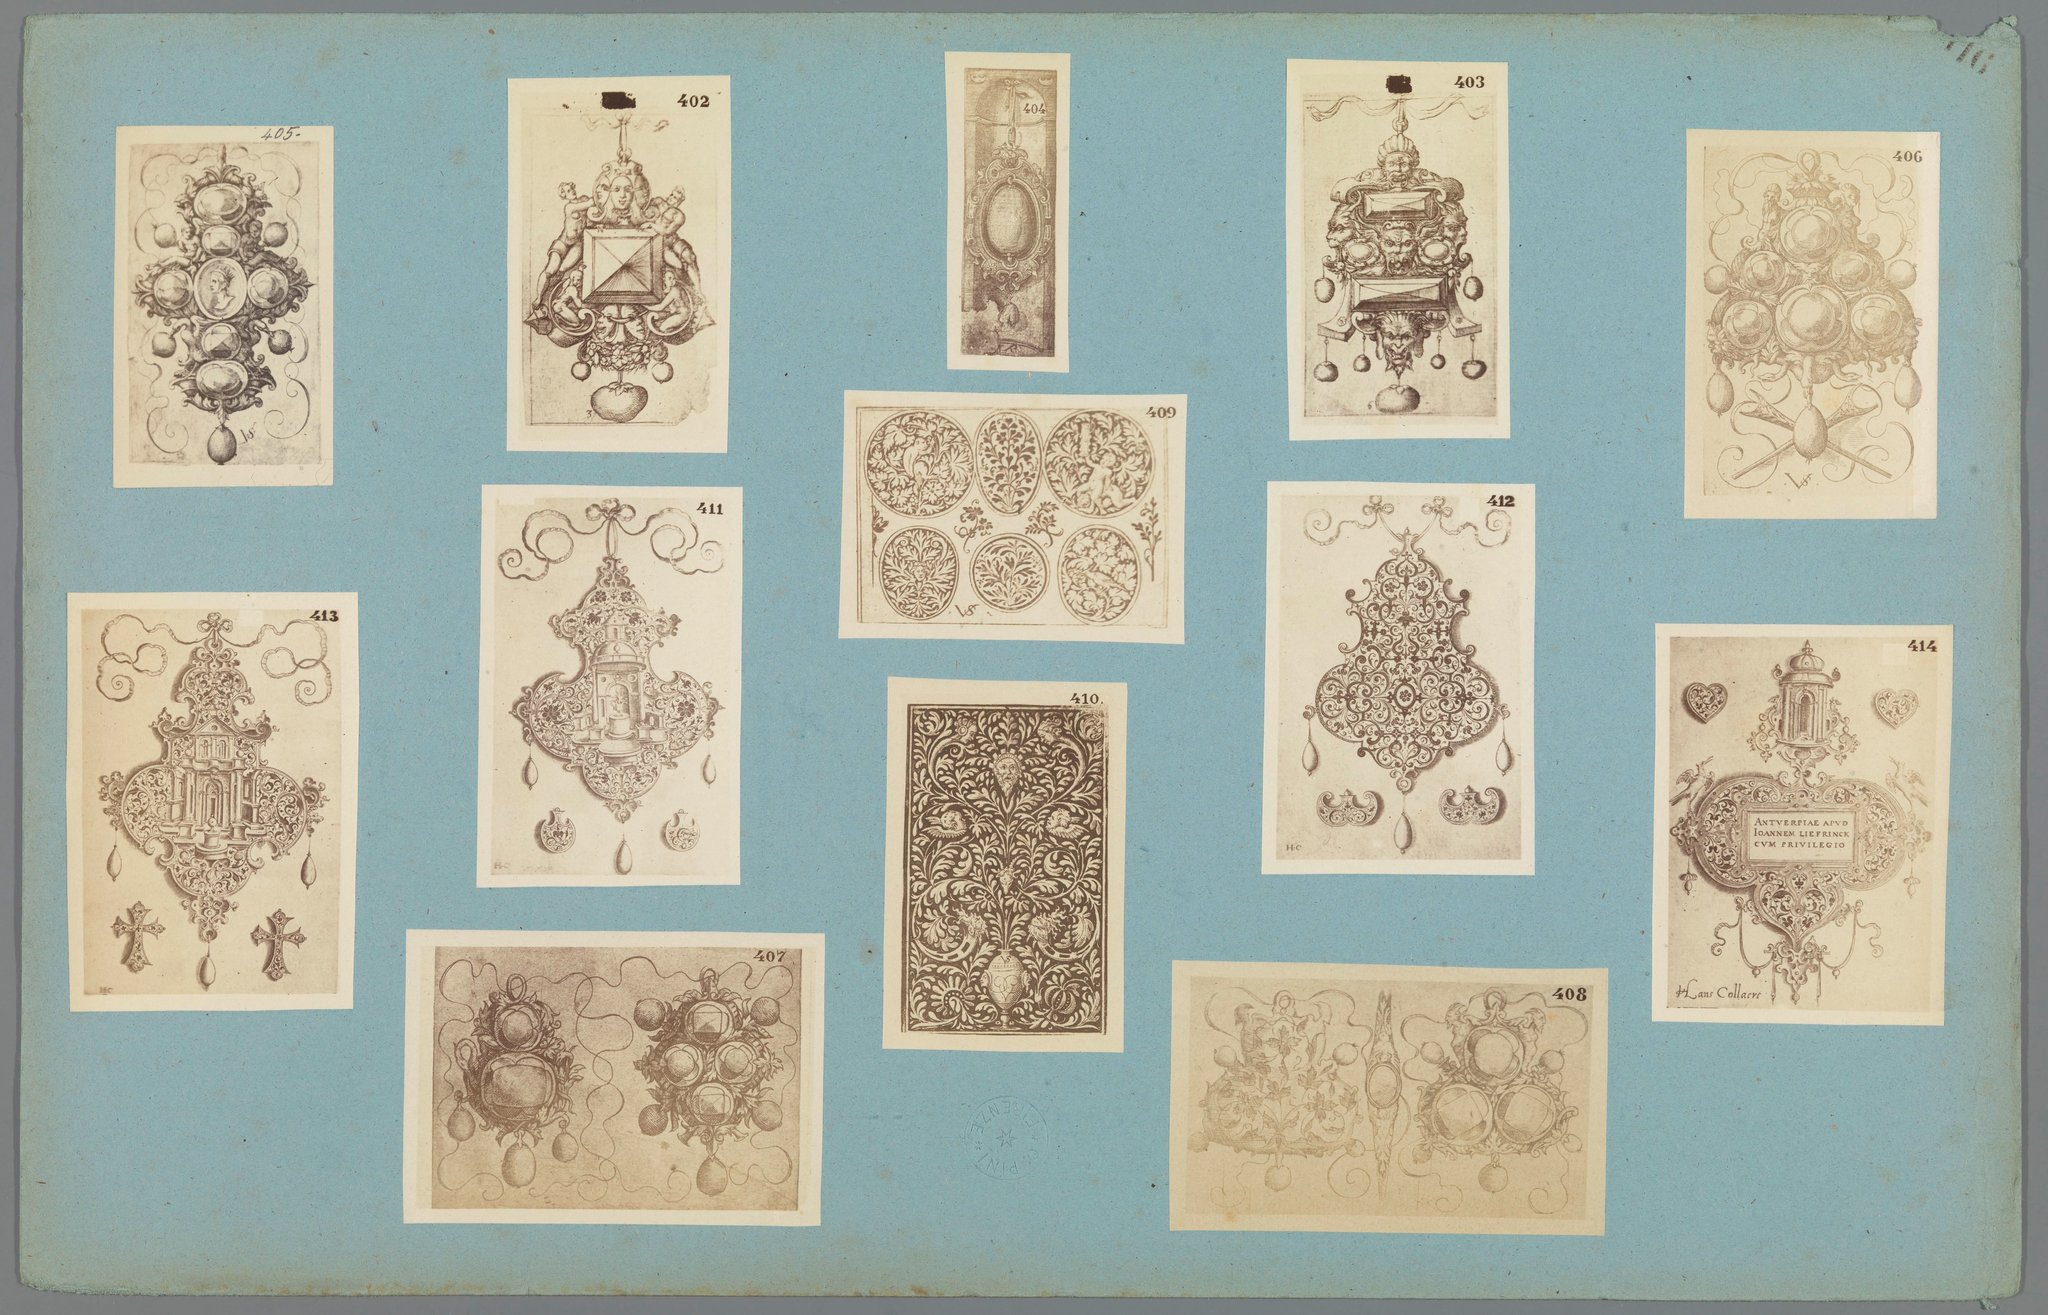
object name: reproduction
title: Dertien fotoreproducties van ornamentprenten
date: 1875-1900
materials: cardboard, photographic support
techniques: albumen print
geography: europe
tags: foliage, tendrils, branches ~ ornament - aa - stylized, ornaments ~ art, fruits and vegetables ~ ornament, mask, mascaron ~ ornament, europe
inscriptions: number: ‘409’, number: ‘116’, number: ‘406’, number: ‘405.’, name: ‘C. PINI FIRENZE’, number: ‘403’, number: ‘414’, number: ‘408’, number: ‘413’, number: ‘407’, number: ‘411’, number: ‘402’, number: ‘404’, number: ‘410.’, collector's mark: Lugt 3937, number: ‘412’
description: Dertien fotoreproducties van ornamentprenten, met onder andere (405) een prent van een ornament met een gekroond portret en profil, (403) een prent van een ornament met monsterkoppen, (414) een prent van een ornament met een tekst en een rond gebouw.